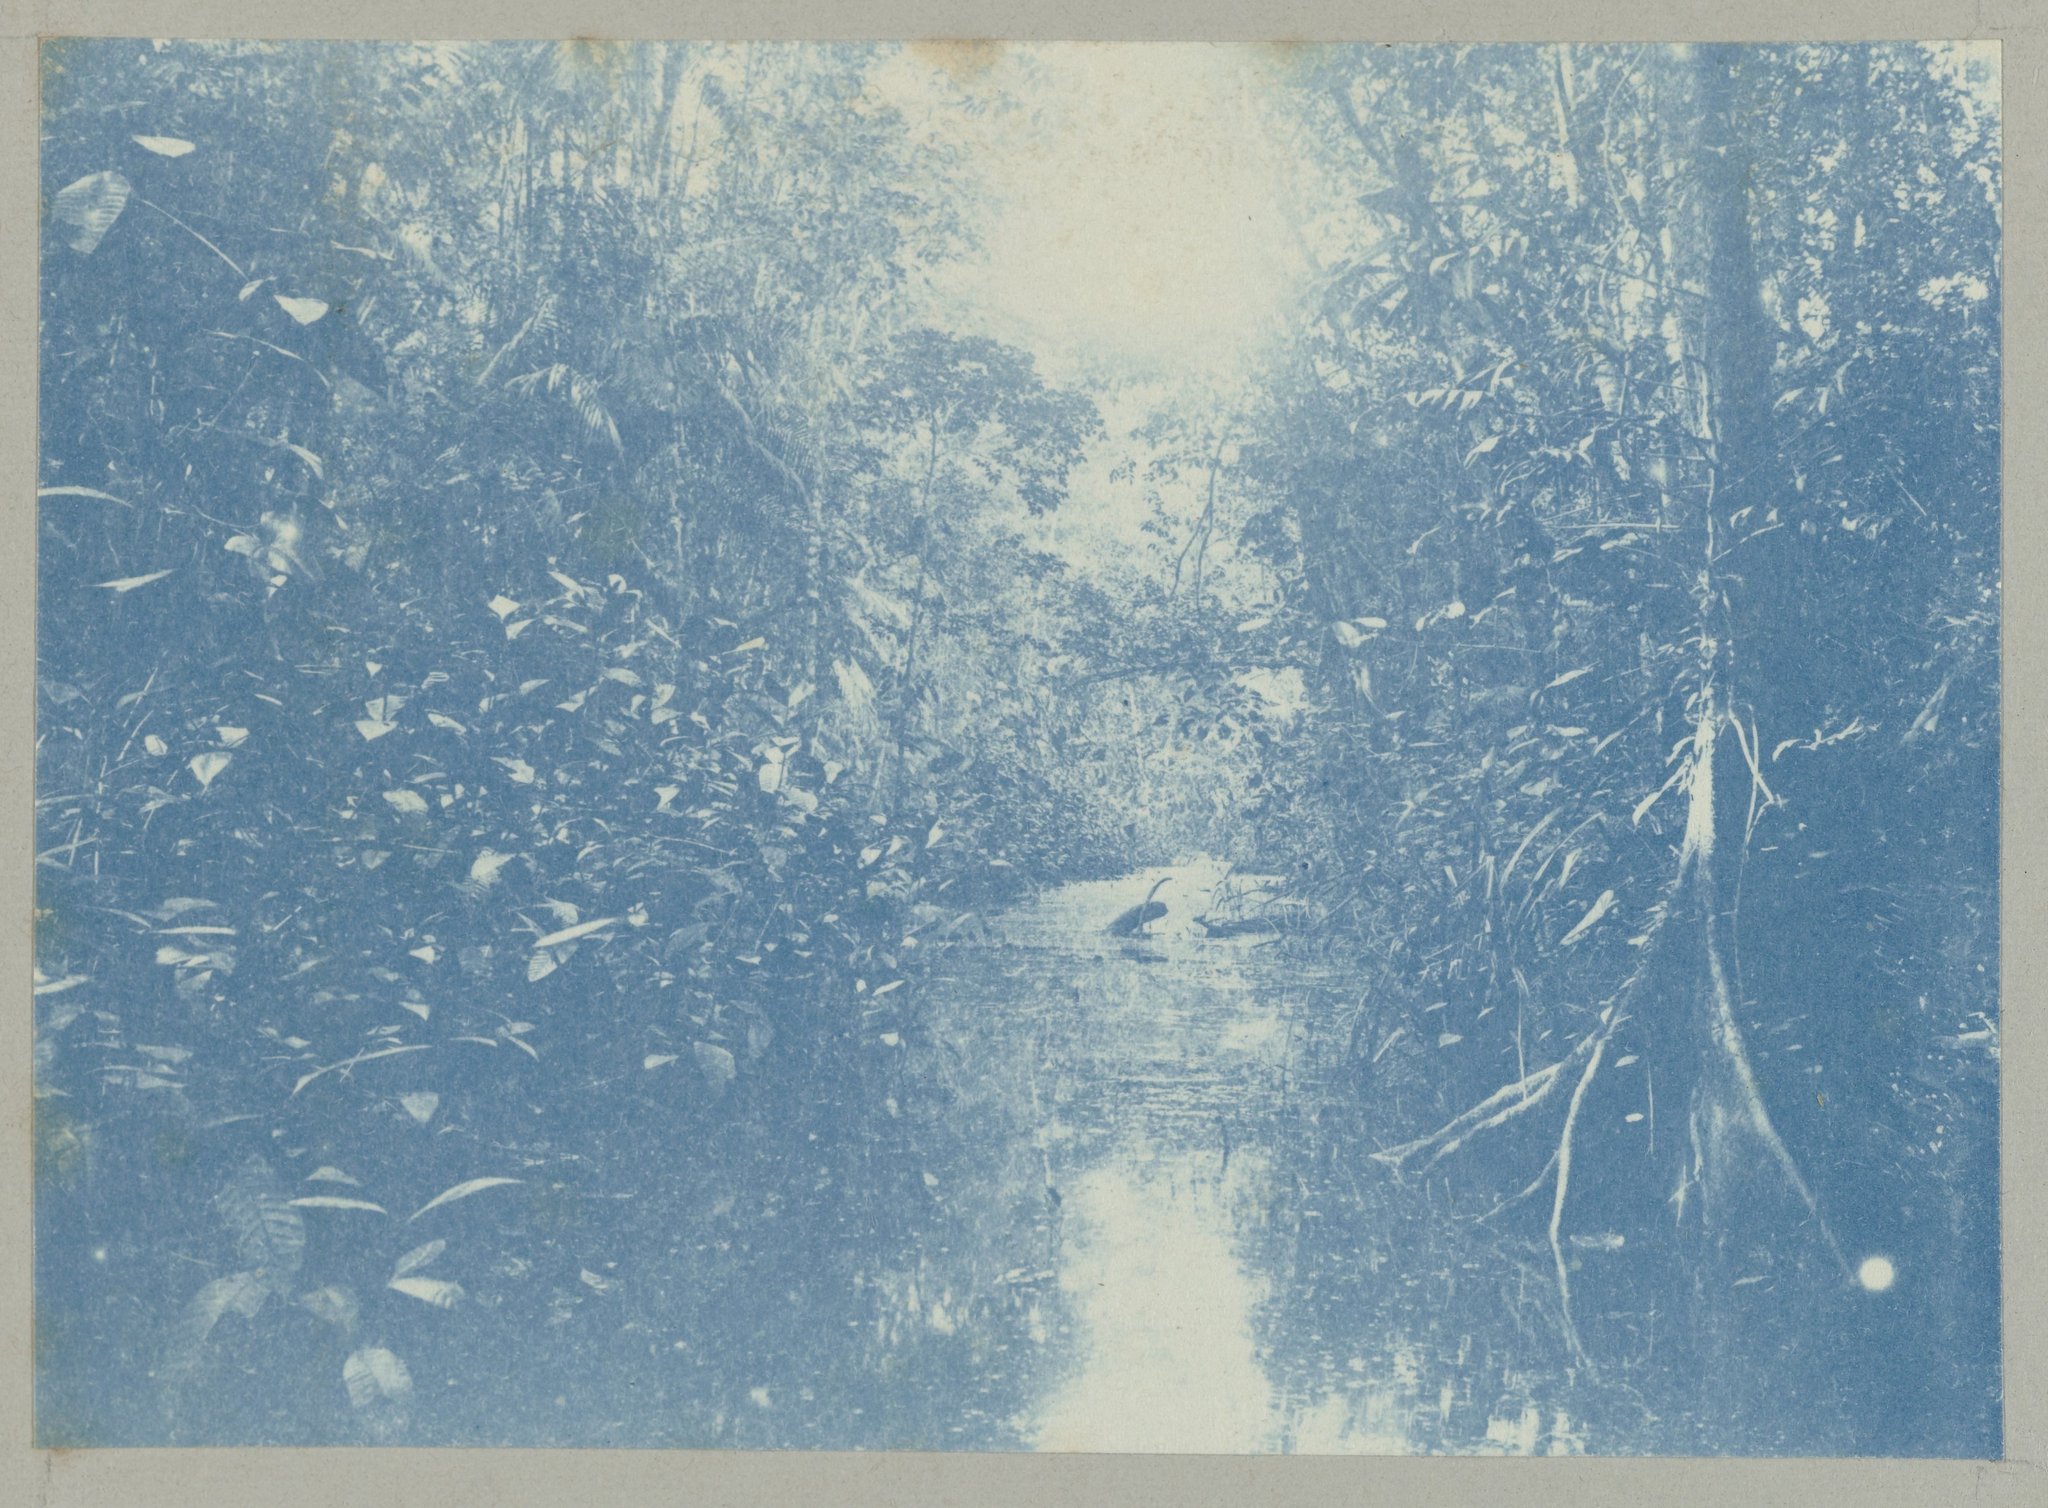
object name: photograph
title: Kreek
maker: hendrik doijer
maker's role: engineer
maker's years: 1863-1925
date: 1903-1910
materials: photographic support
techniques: cyanotype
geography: suriname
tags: suriname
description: Kreek in het oerwoud. Onderdeel van het fotoalbum Souvenir de Voyage (deel 2), over het leven van de familie Doijer in en rond de plantage Ma Retraite in Suriname in de jaren 1903-1910.